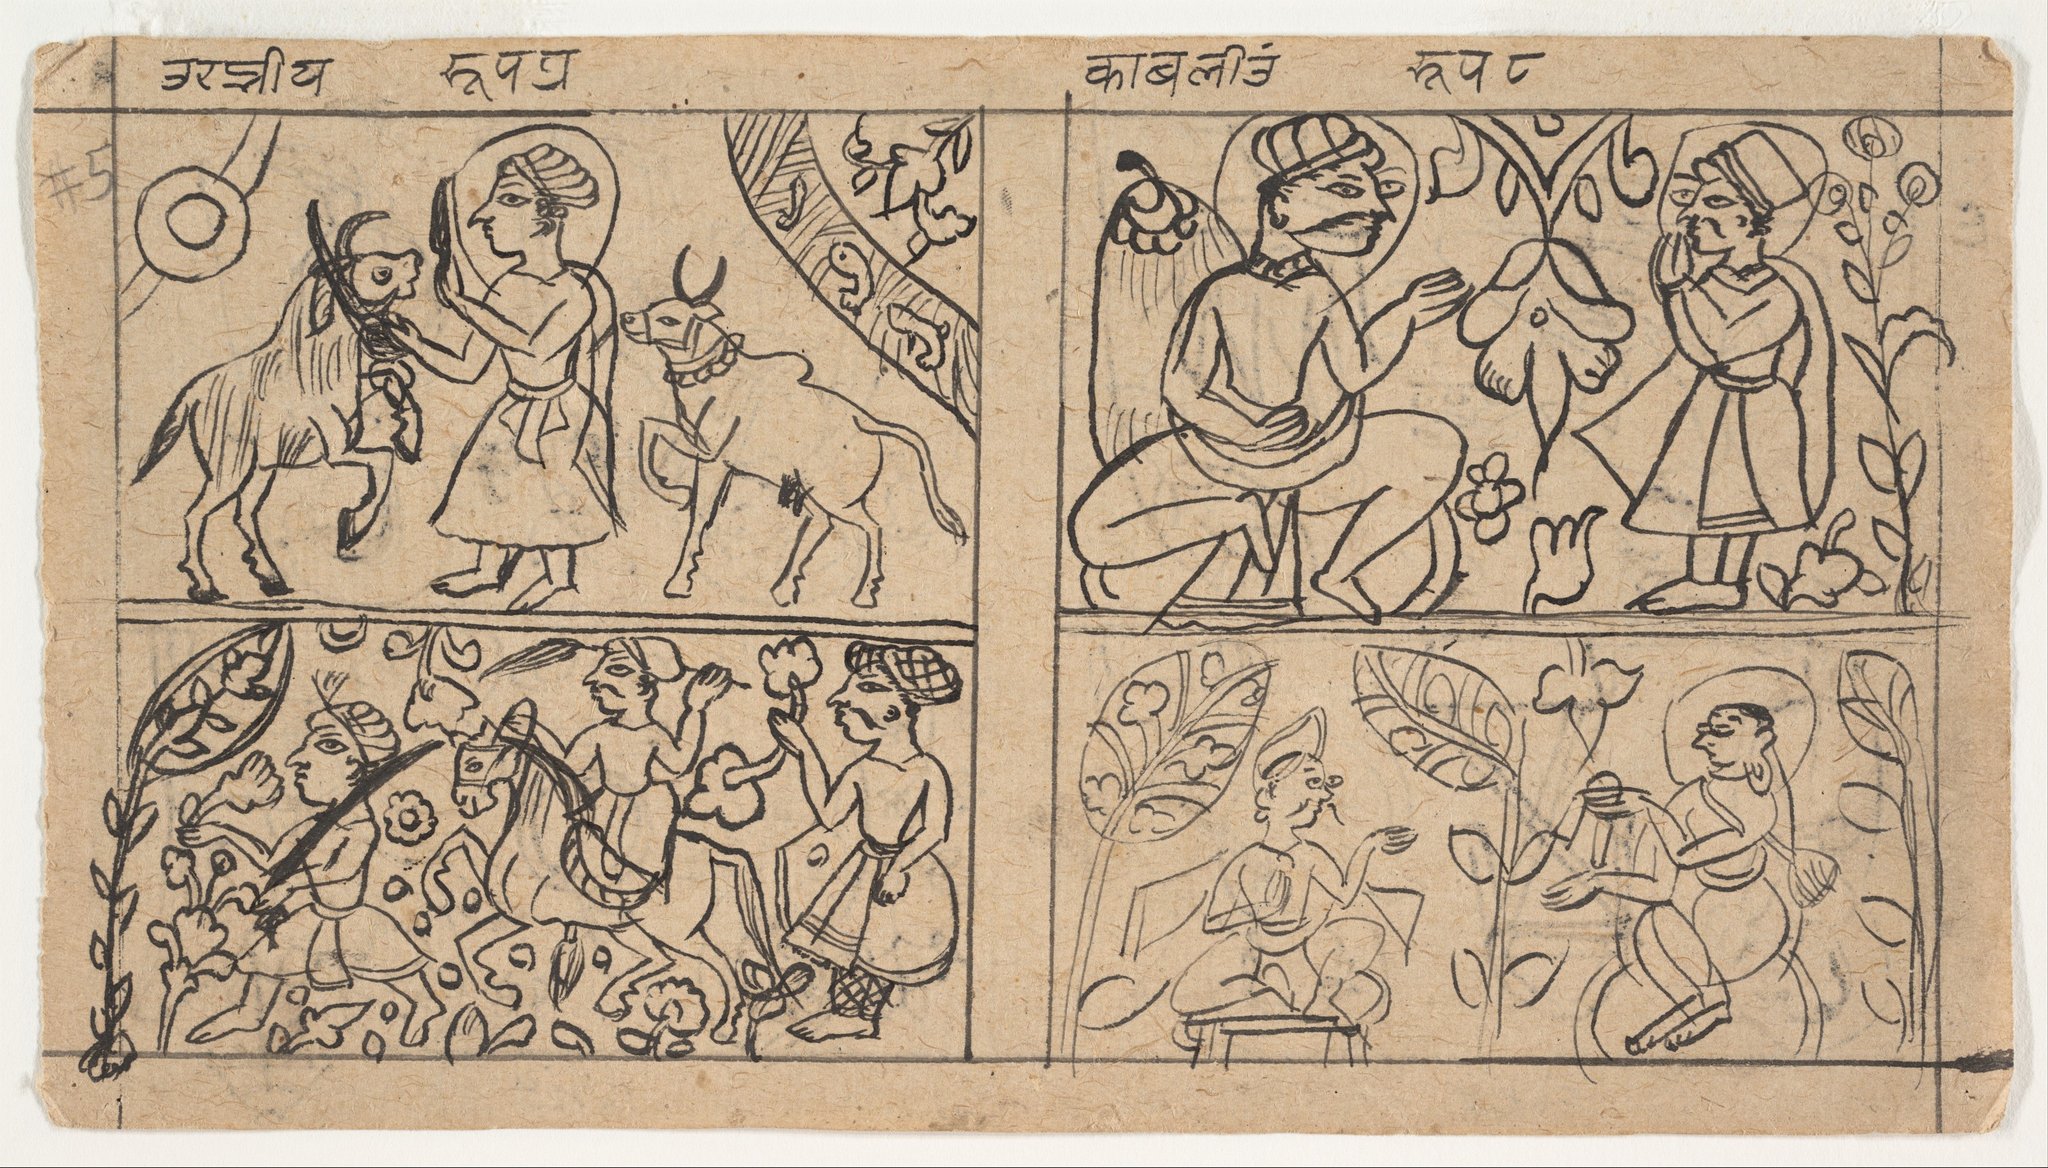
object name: folio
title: Page from a pattern book for a Uttaradhyayana sutra manuscript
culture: indian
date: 1675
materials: ink, paper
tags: men,cows,horses